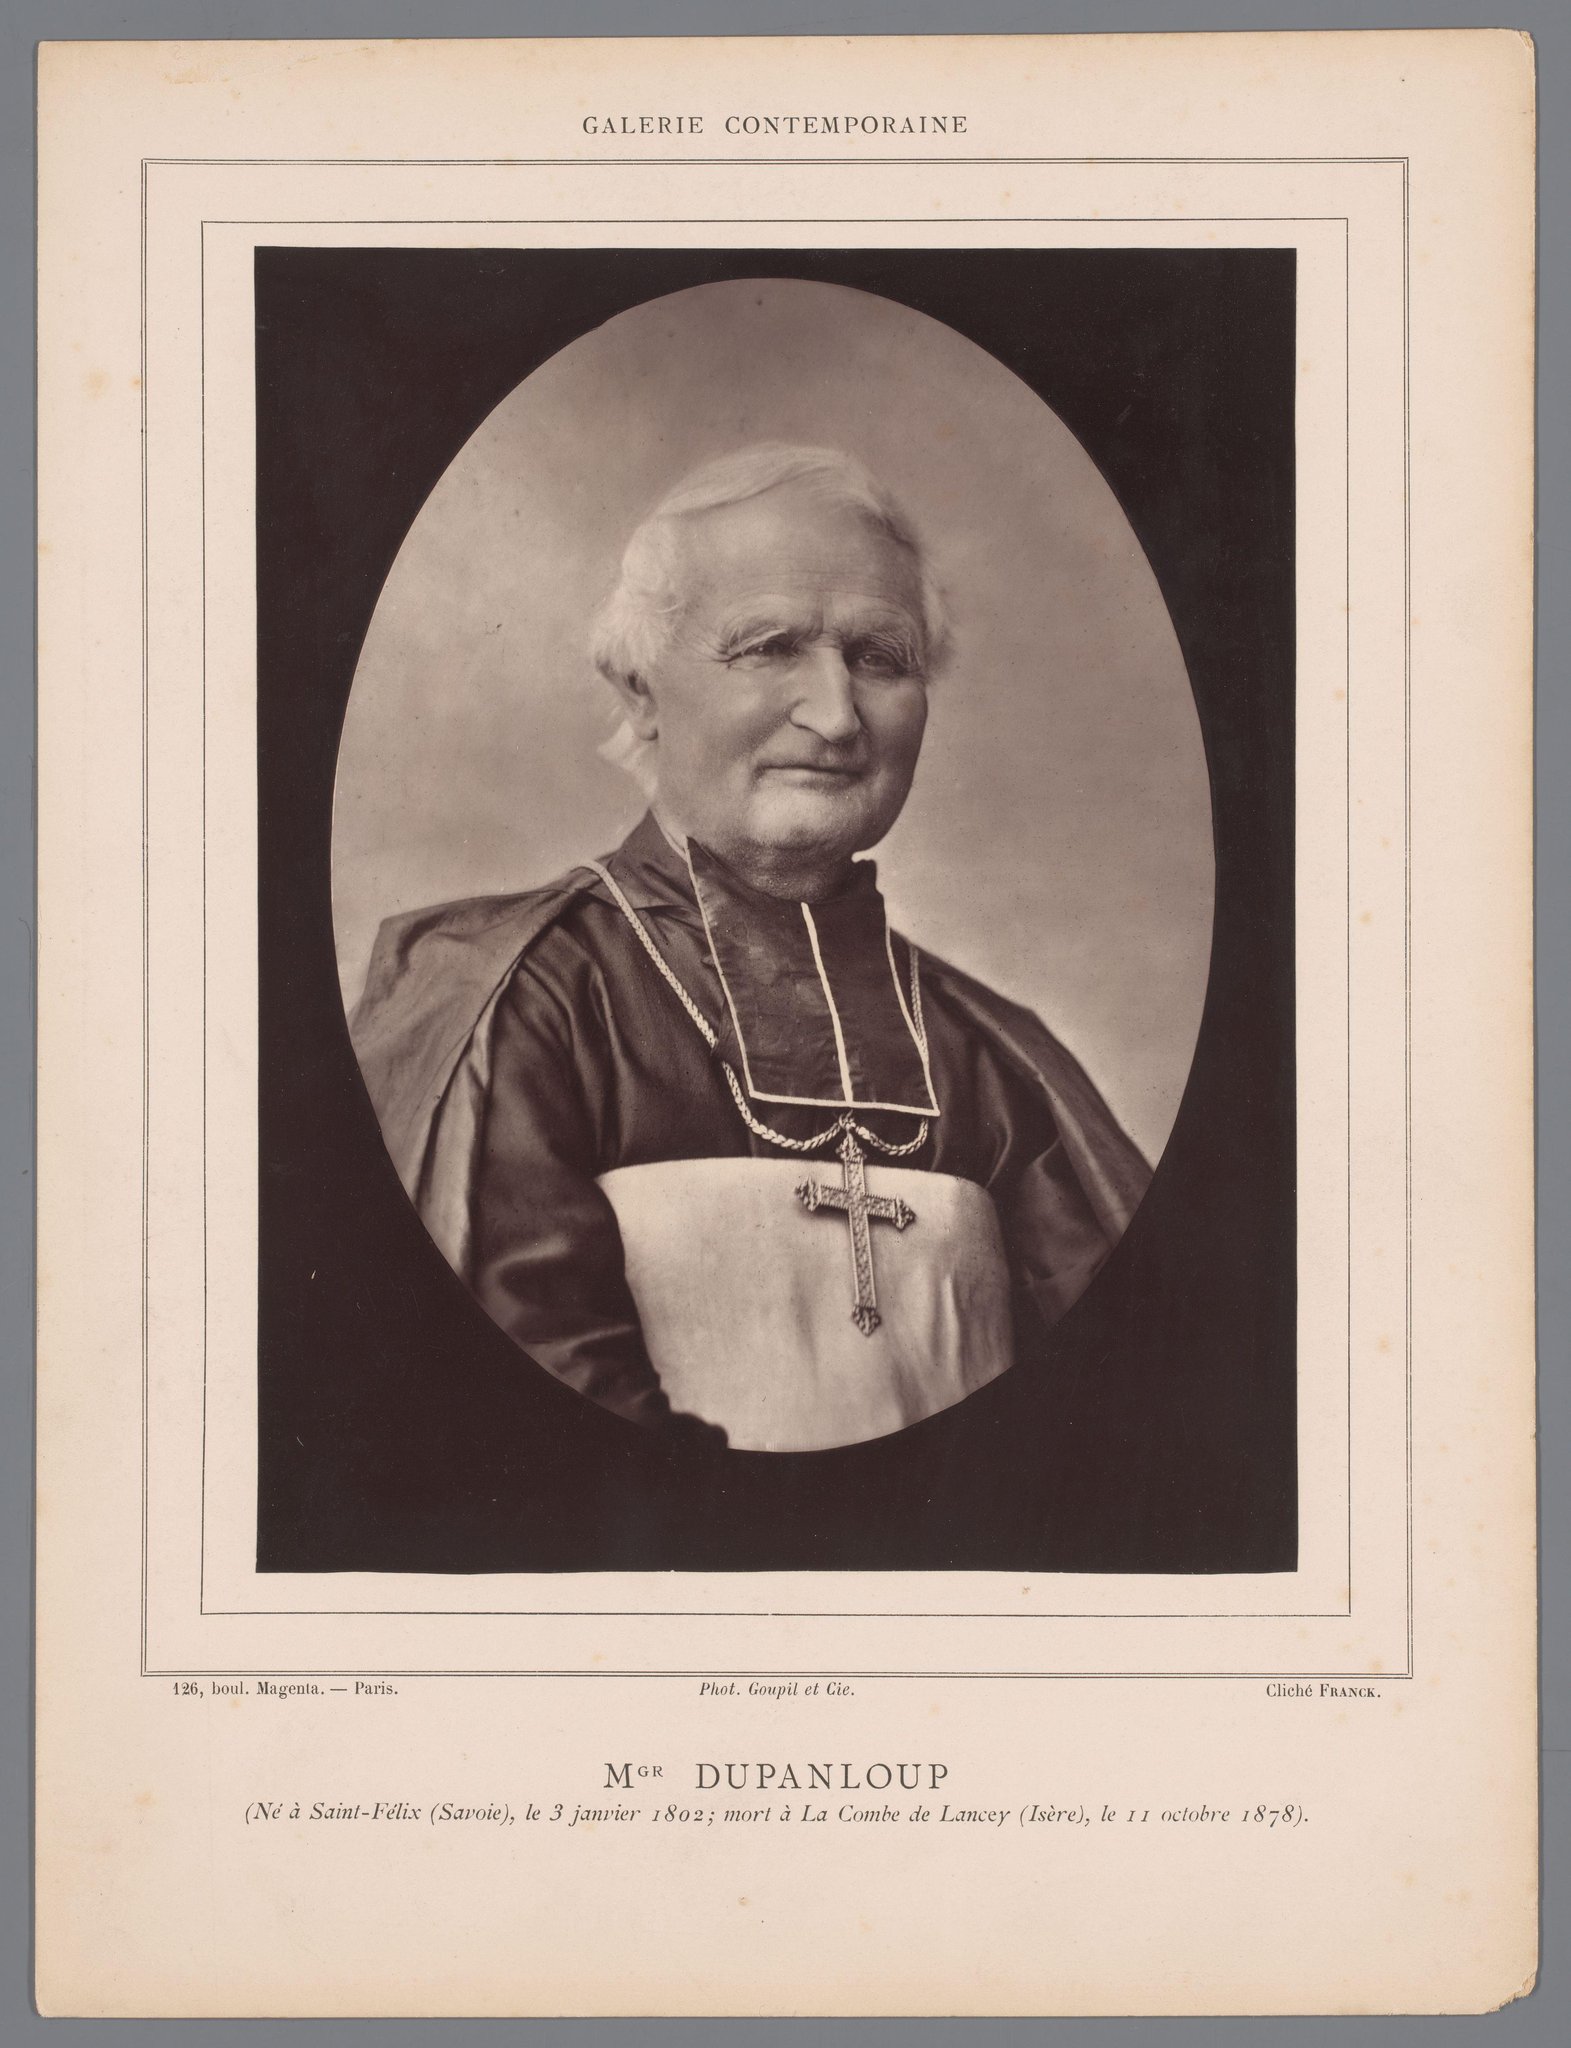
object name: photograph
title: Galérie contemporaine, litéraire, artistique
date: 1876-1878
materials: cardboard, paper, photographic support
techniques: woodburytype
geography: paris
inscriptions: caption: ‘126, boul. Magenta. - Paris.’, caption: ‘Phot. Goupil & Cie.’, caption: ‘Cliché FRANCK.’, caption: ‘Mgr Dupanloup//(Né à Saint-Félix (Savoie), le 3 janvier 1802; mort à La Combe de Lancey (Isère) le 11 octobre 1878).’, inscription: ‘GALERIE CONTEMPORAINE’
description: Portret van Mgr. Dupanloup, een geestelijke in ambtskleding, met een kruis om zijn nek. Plaat uit tijdschrift.